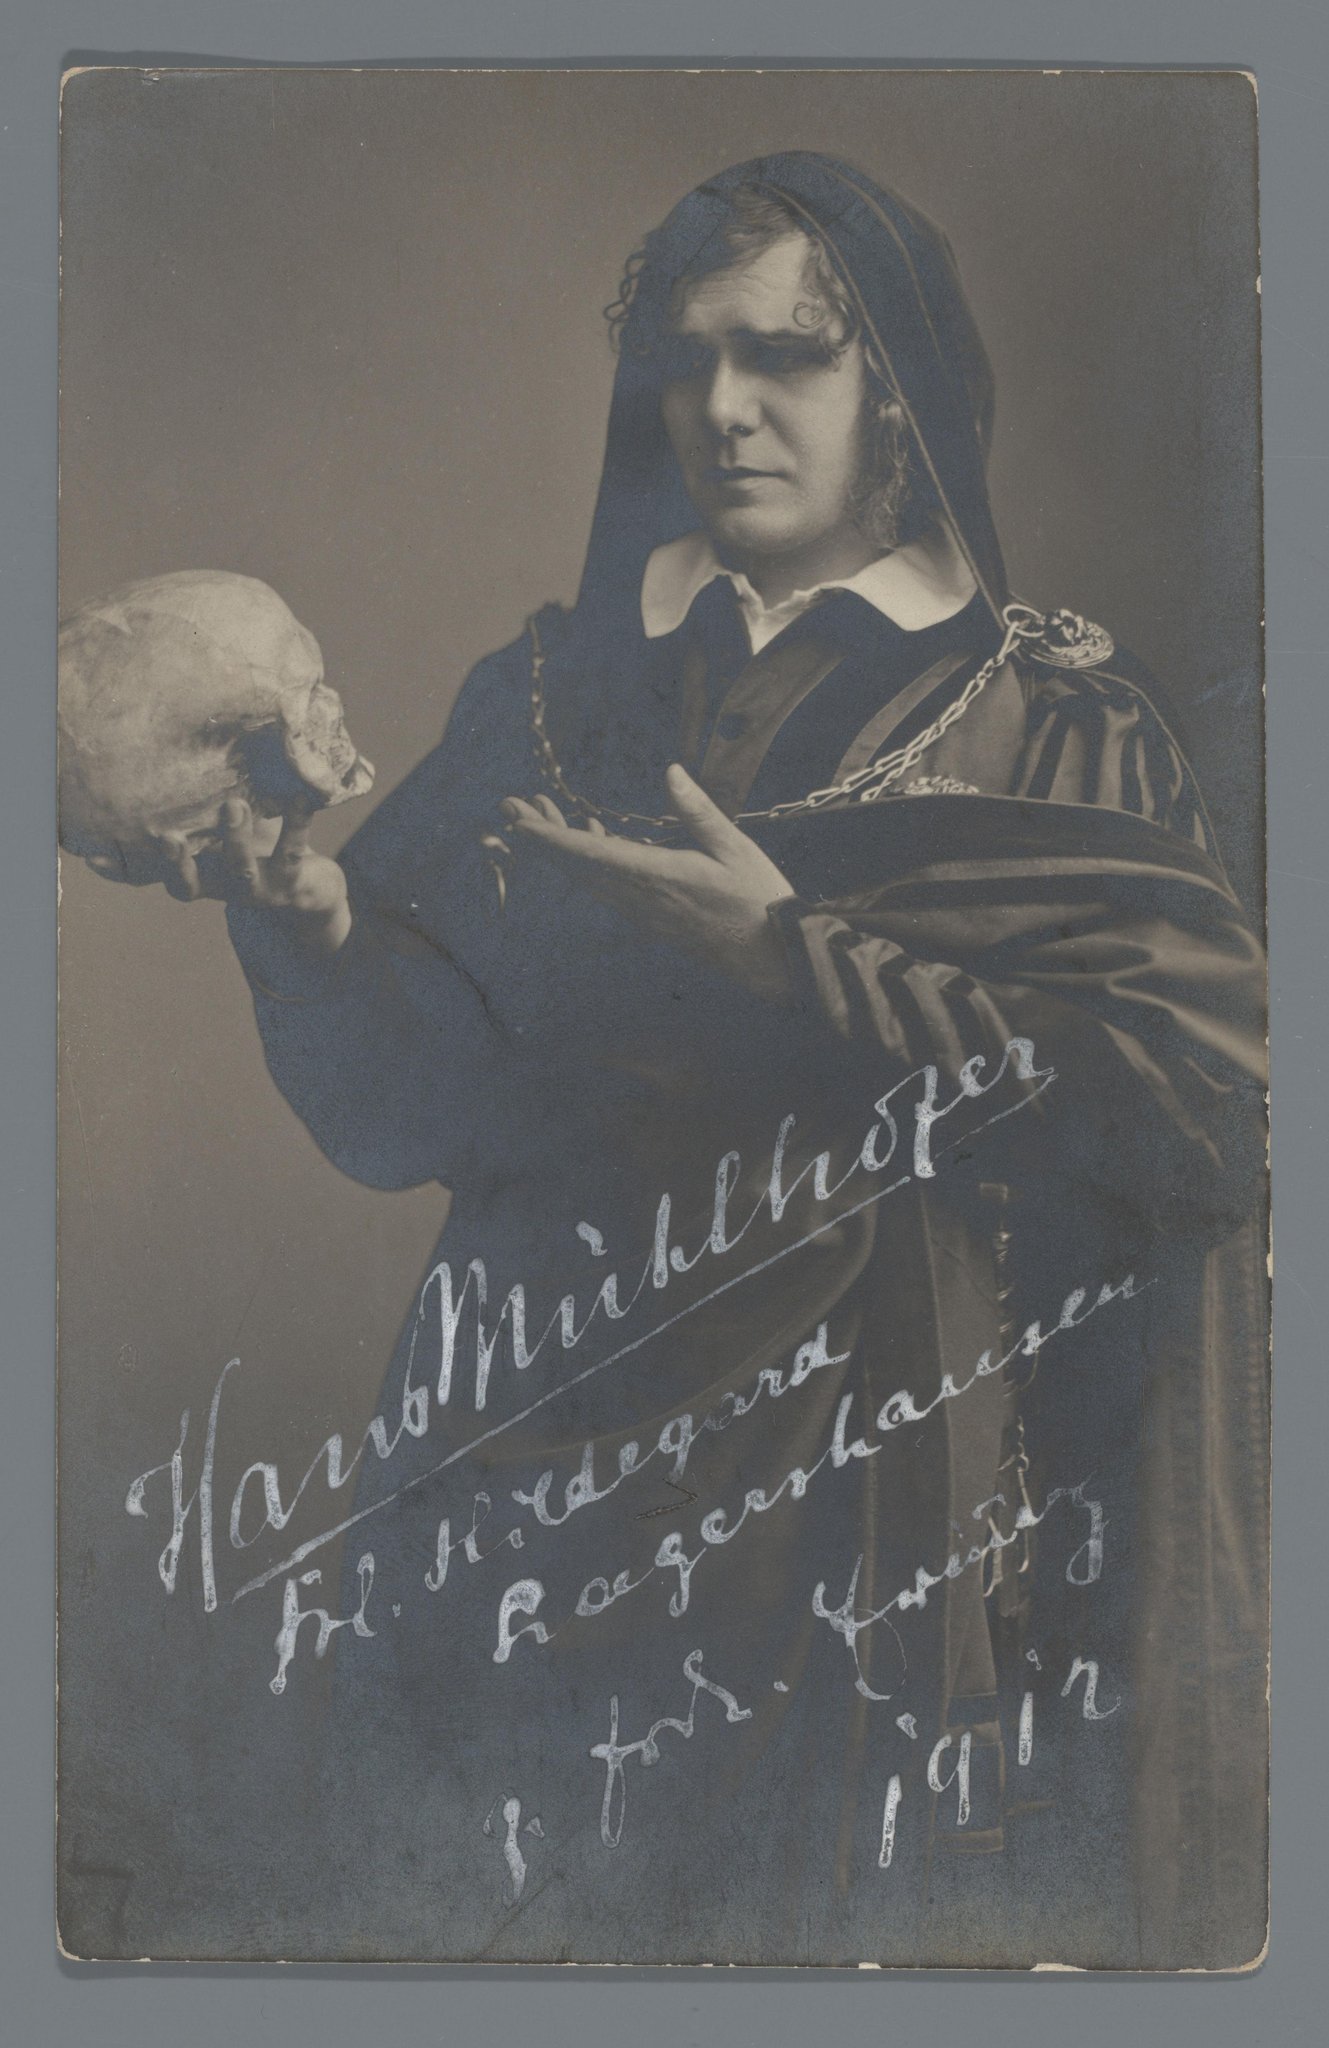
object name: ansichtkaart, prentbriefkaart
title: Portret van de acteur Hans Mühlhofer met schedel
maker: robert fendius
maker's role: fotograaf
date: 1900-1932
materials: photographic support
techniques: gelatin silver print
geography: magdeburg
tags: berlin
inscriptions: dedication